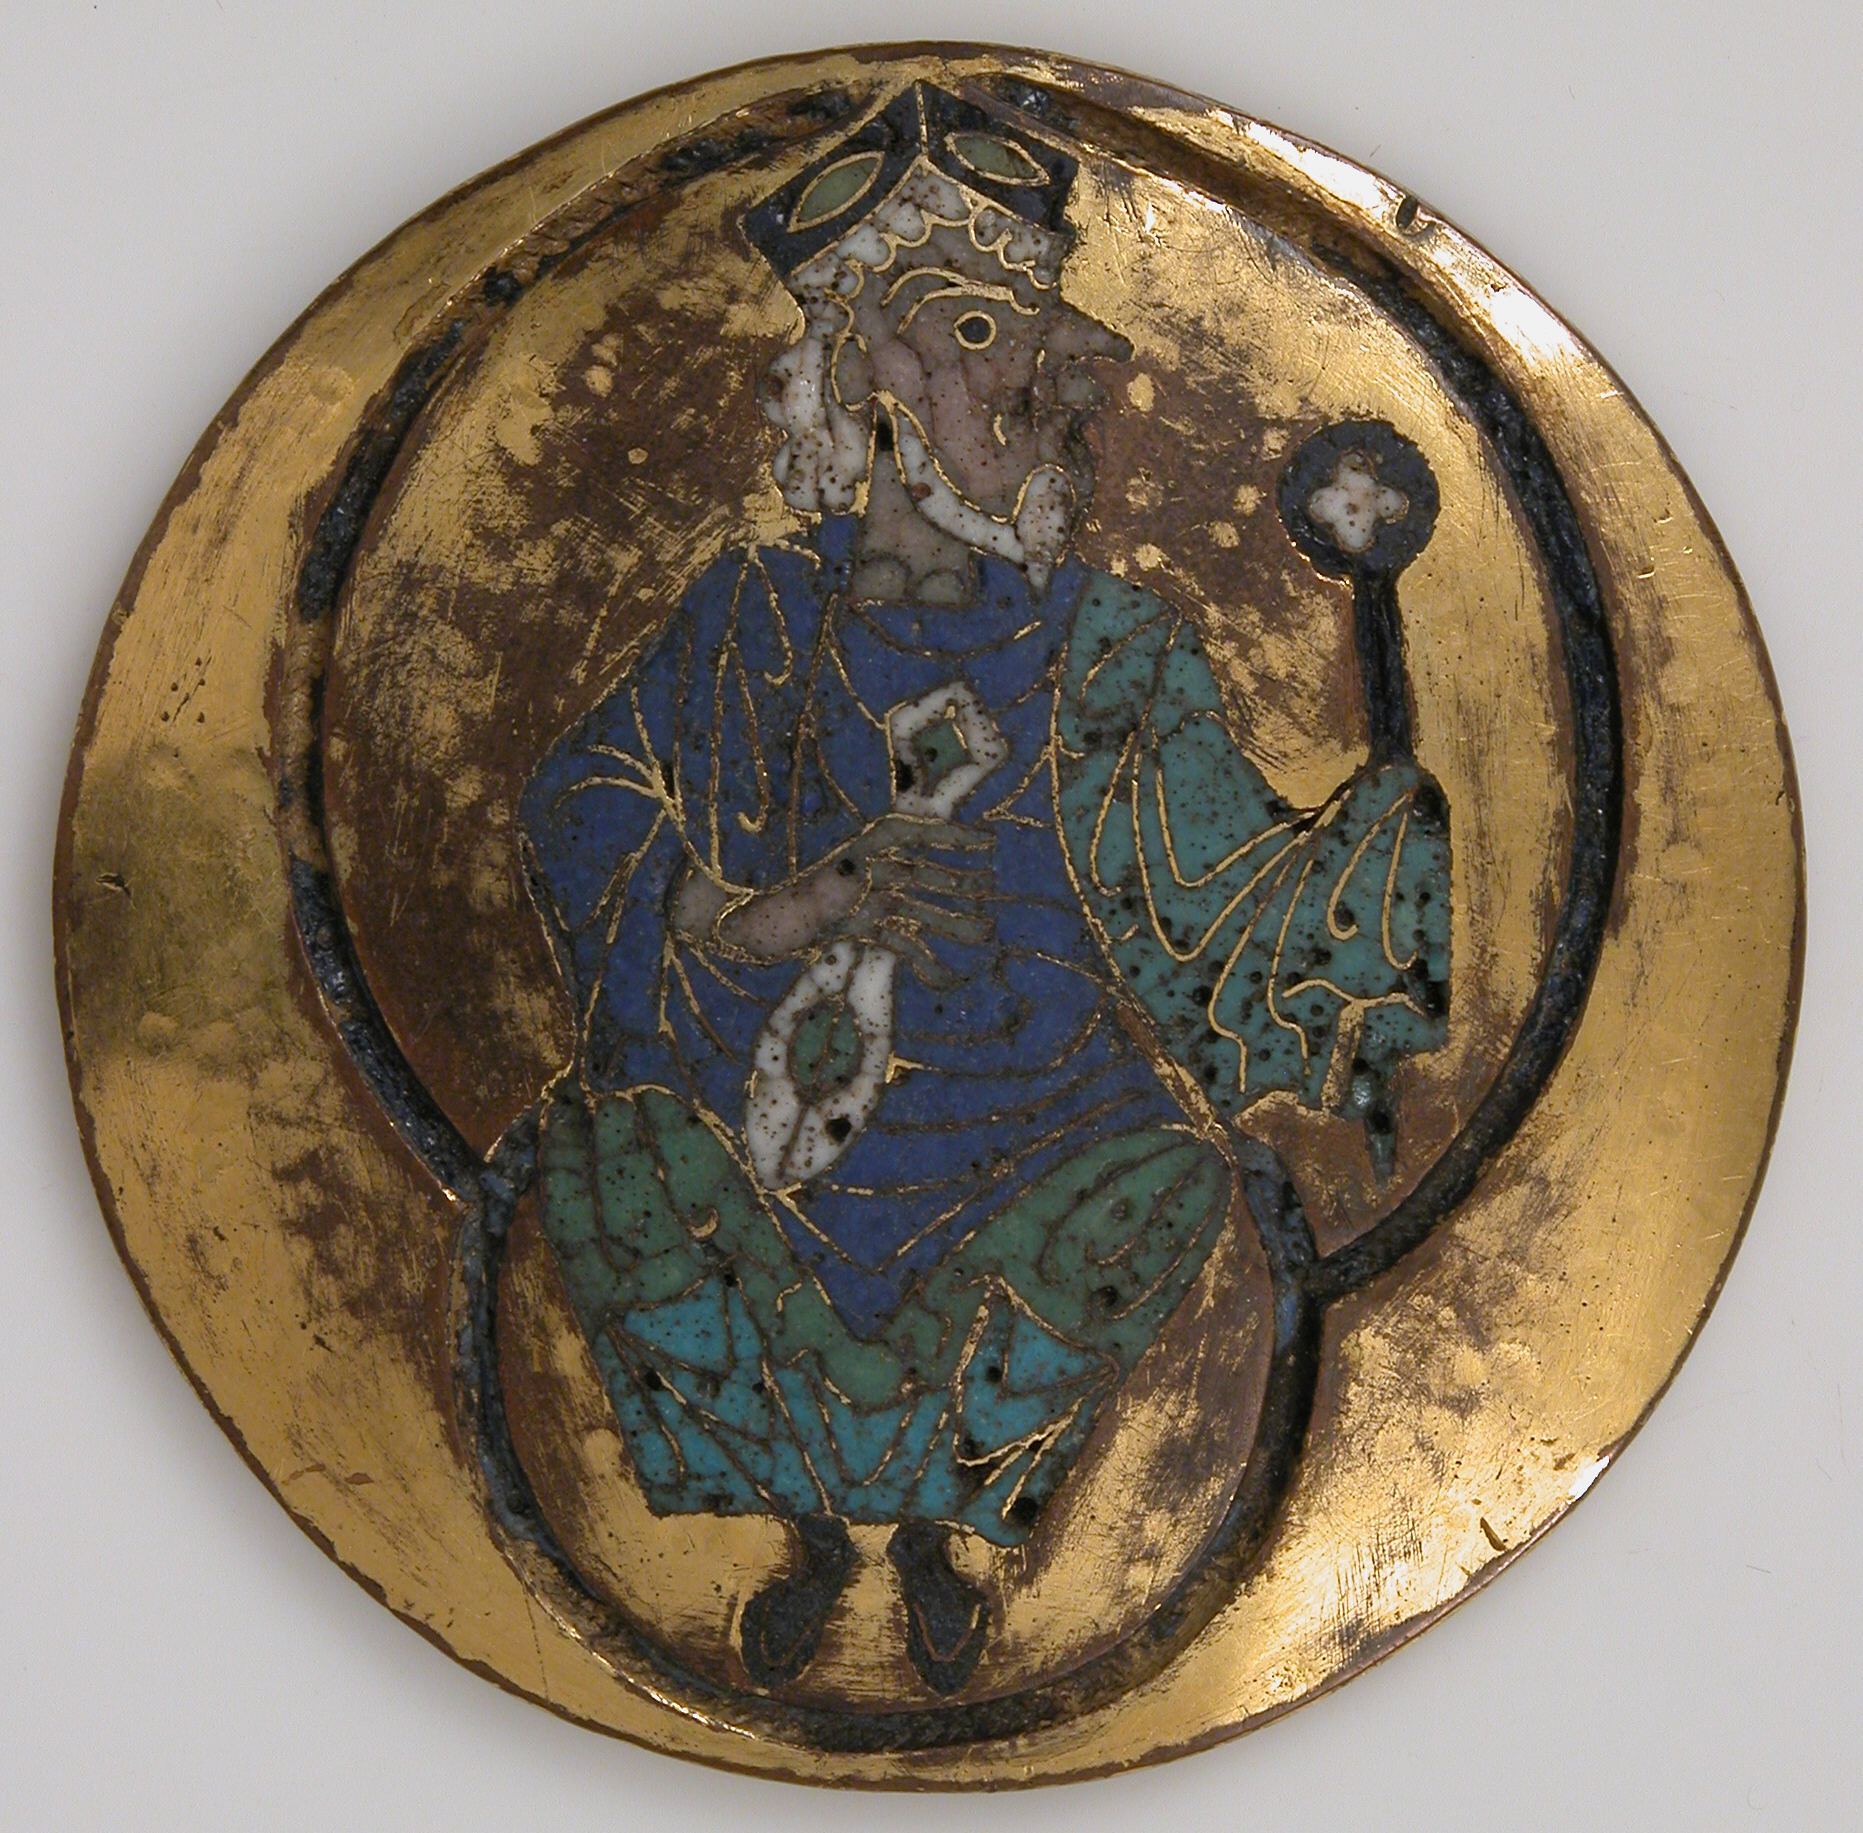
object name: roundel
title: Elder of the Apocalypse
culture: french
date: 1100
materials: copper, enamel, gilt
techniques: enamel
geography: france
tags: men